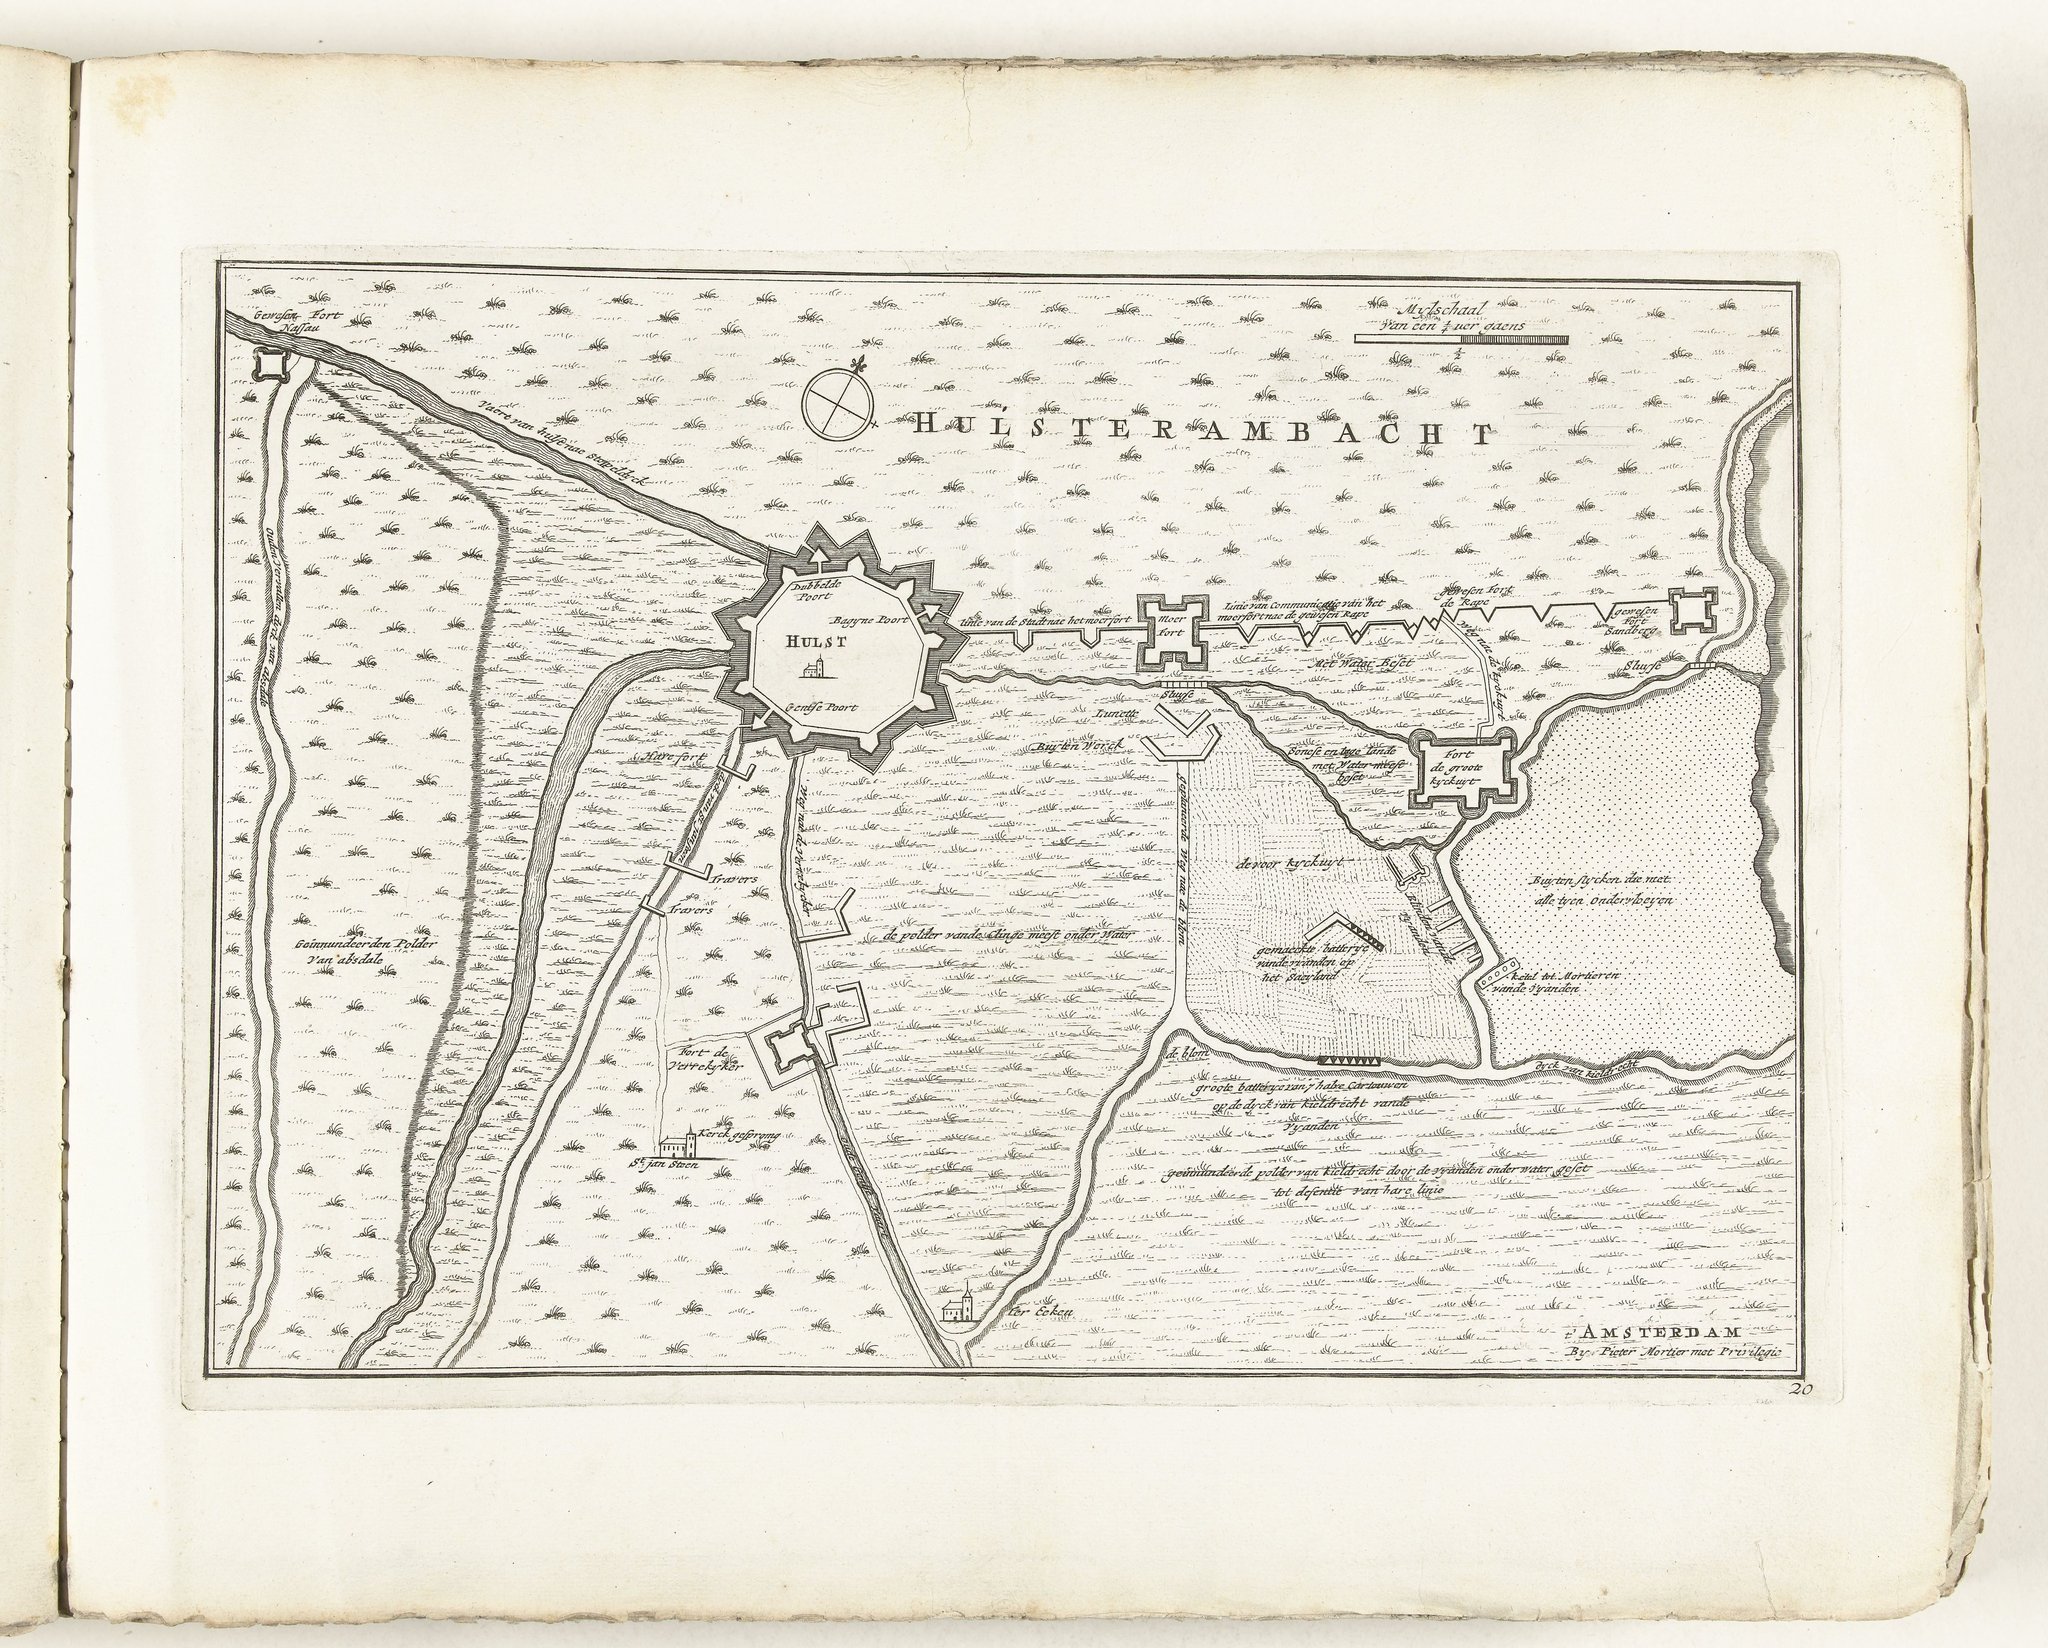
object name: print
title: Les Forces de l'Europe, Asie, Afrique et Amerique, ou description des principales villes avec leurs fortifications. Dessignées par les meilleurs ingenieurs, particulierement celles qui sont sous la domination de la France (...) et ornées de plusieurs superbes edifices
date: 1702-1703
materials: paper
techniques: etching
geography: northern netherlands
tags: fortress, maps of separate countries or regions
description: Plattegrond met de verdedigingswerken om de stad Hulst en de omgeving. Plaat nr. 20 in het prentwerk bestaande in totaal uit 276 genummerde platen van vermaarde sterke steden en vestingen in het kader van de Spaanse Successieoorlog. Voor het merendeel zijn deze platen gekopieerd naar de anonieme Franse platen: in Les forces de l'Europe en in: Le theatre de la guerre, dans les Pays-Bas, beide oorspronkelijk uitgegeven door Nicolas de Fer te Parijs (1693-1697) in het kader van de Negenjarige Oorlog. Titel en opschriften in het Frans.